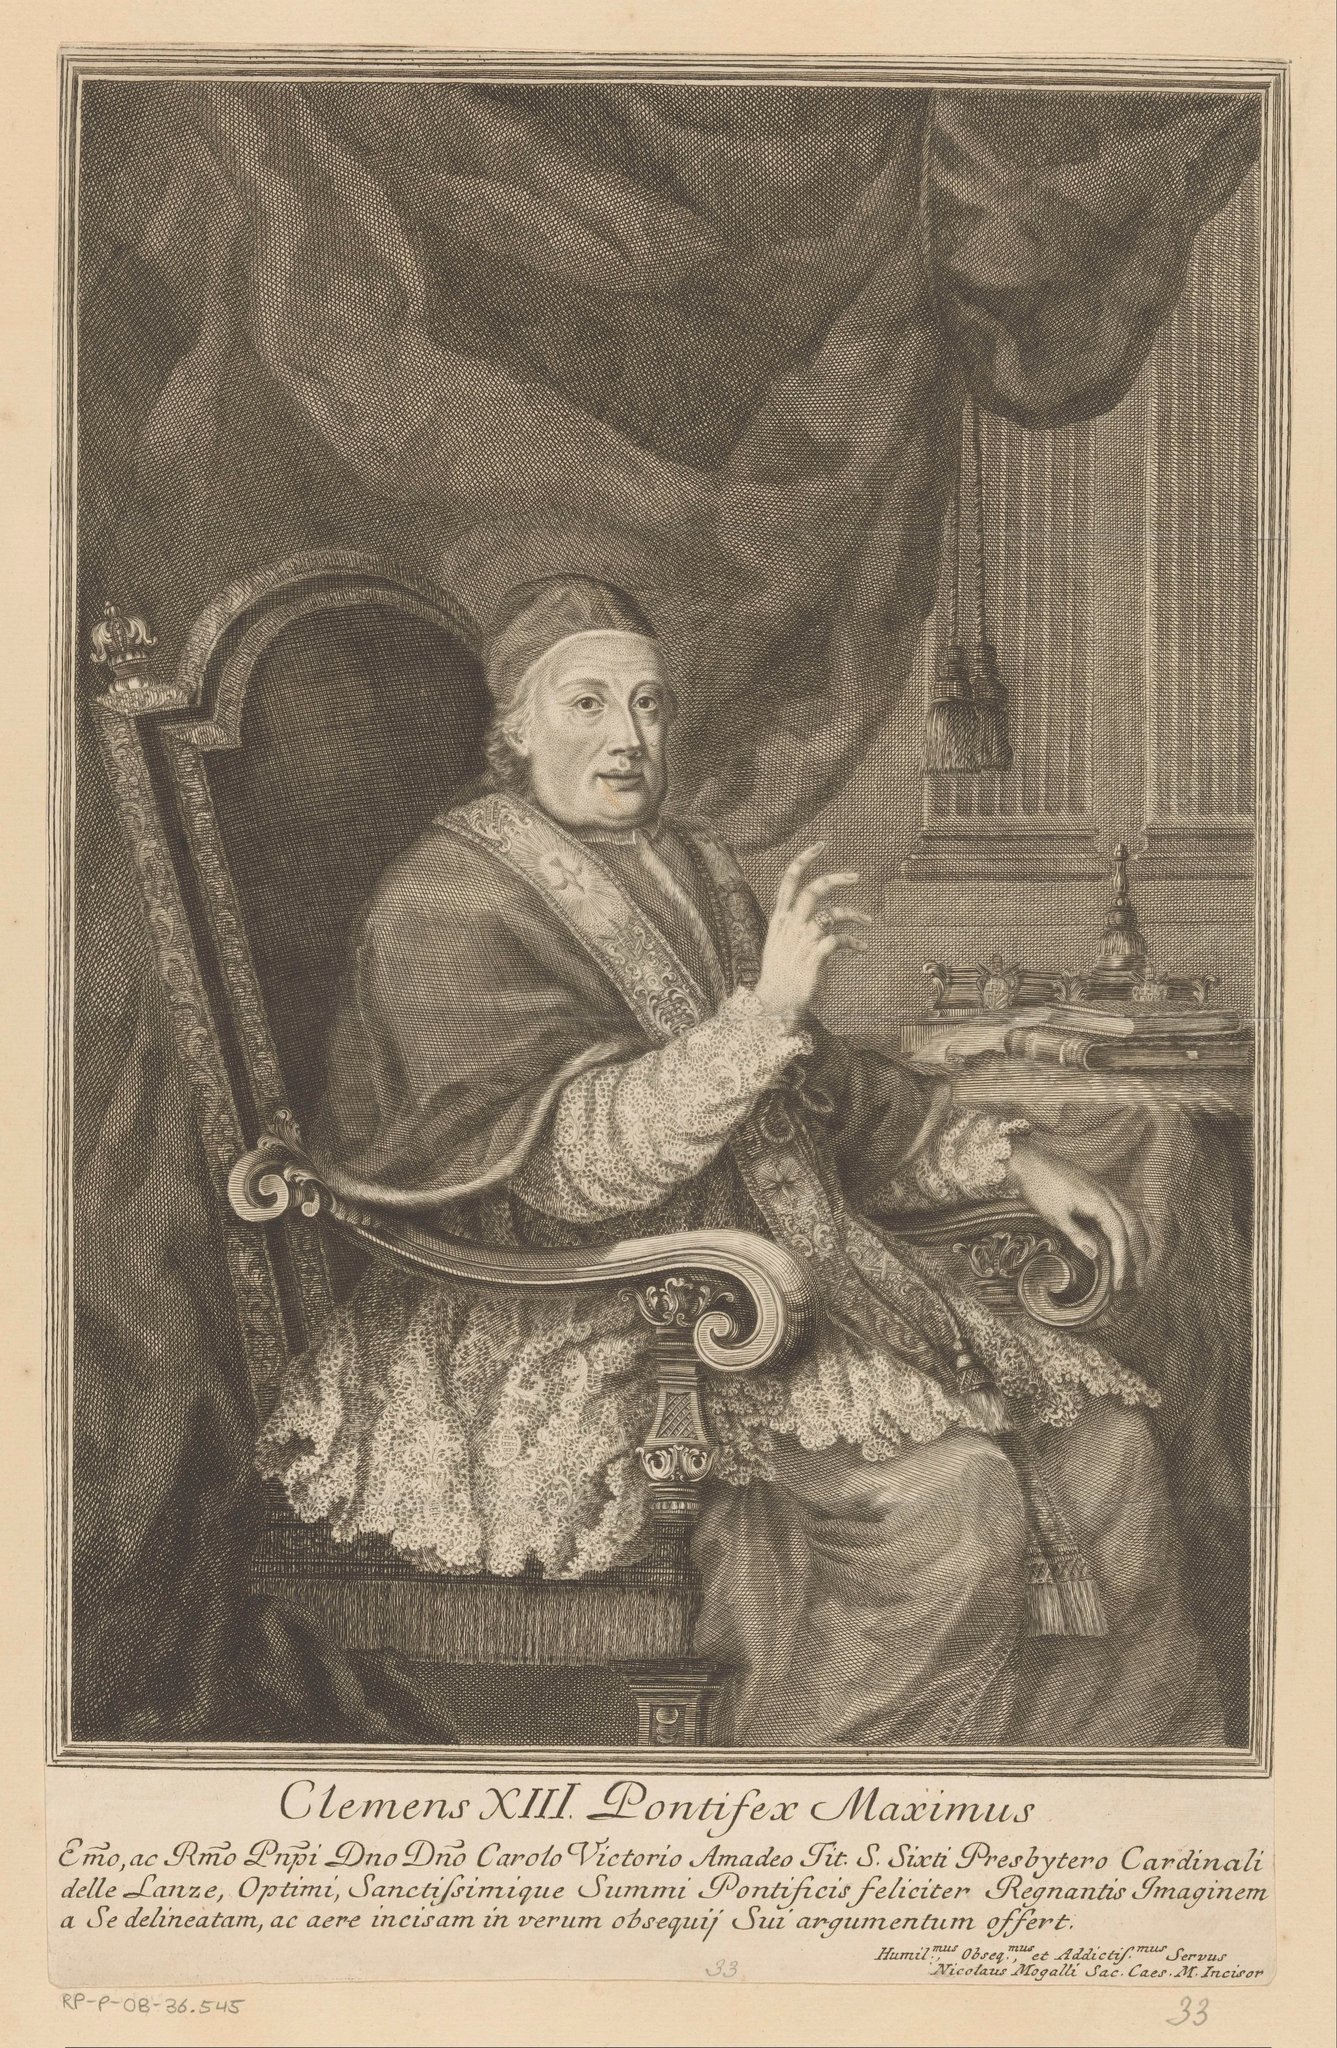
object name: print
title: Portret van paus Clemens XIII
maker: nicolo mogalli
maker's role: print maker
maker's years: 1723-1767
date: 1758-1767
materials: paper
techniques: etching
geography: italy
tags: clemens xiii, historical persons, pope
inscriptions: collector's mark: Lugt 240